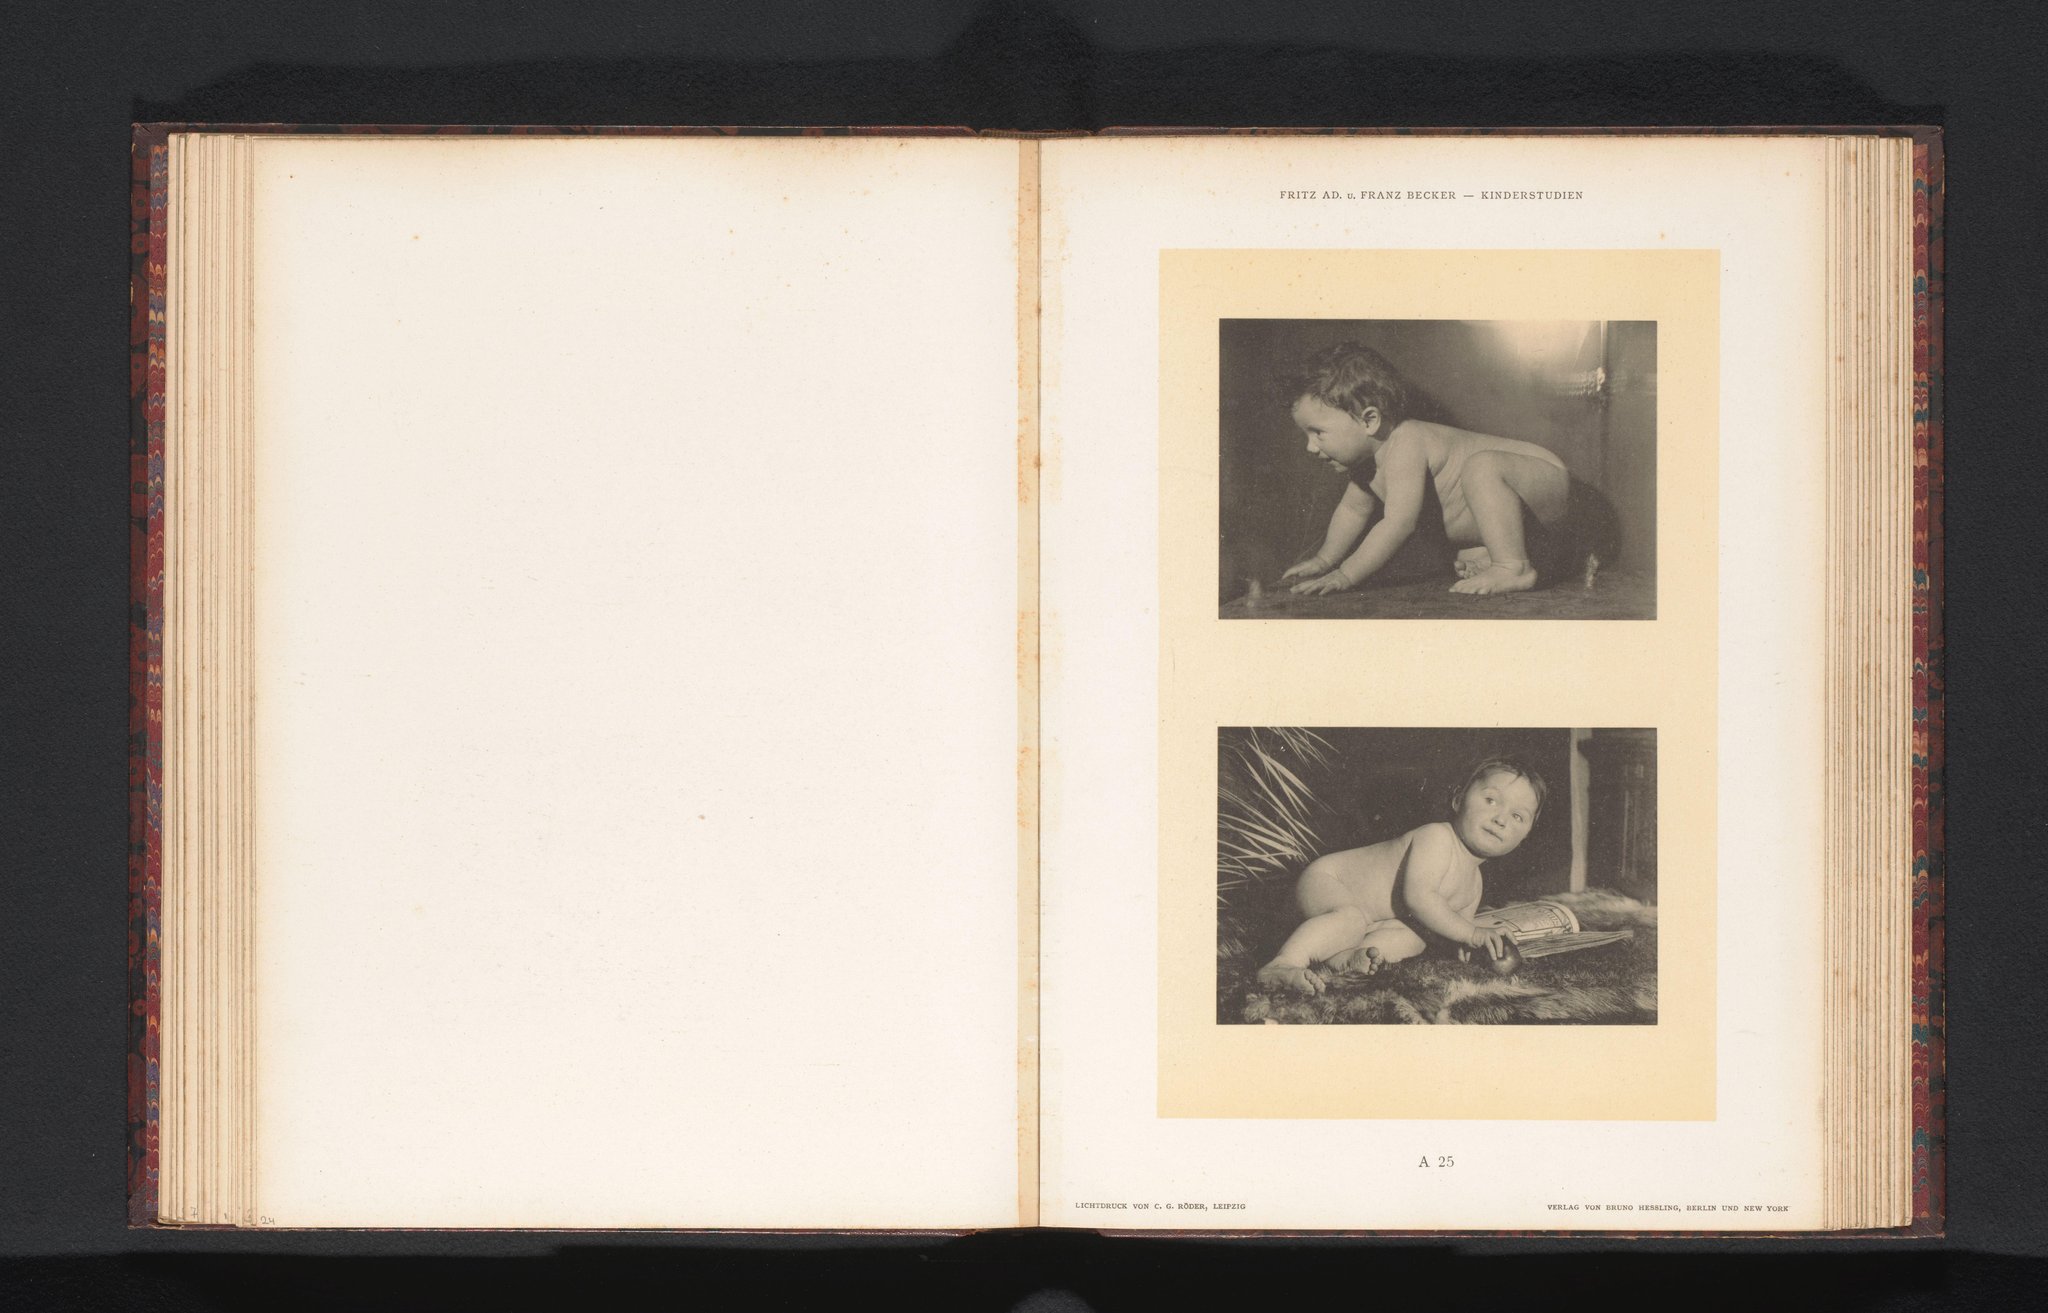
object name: page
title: Twee afbeeldingen van een naakt kind, kruipend en liggend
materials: paper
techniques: photograph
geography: leipzig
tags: lying on one side, with uplifted upper part of the body and leaning on the arm, squatting, crouching figure, tot, toddler ~ the ages of man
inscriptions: number: ‘A 25’